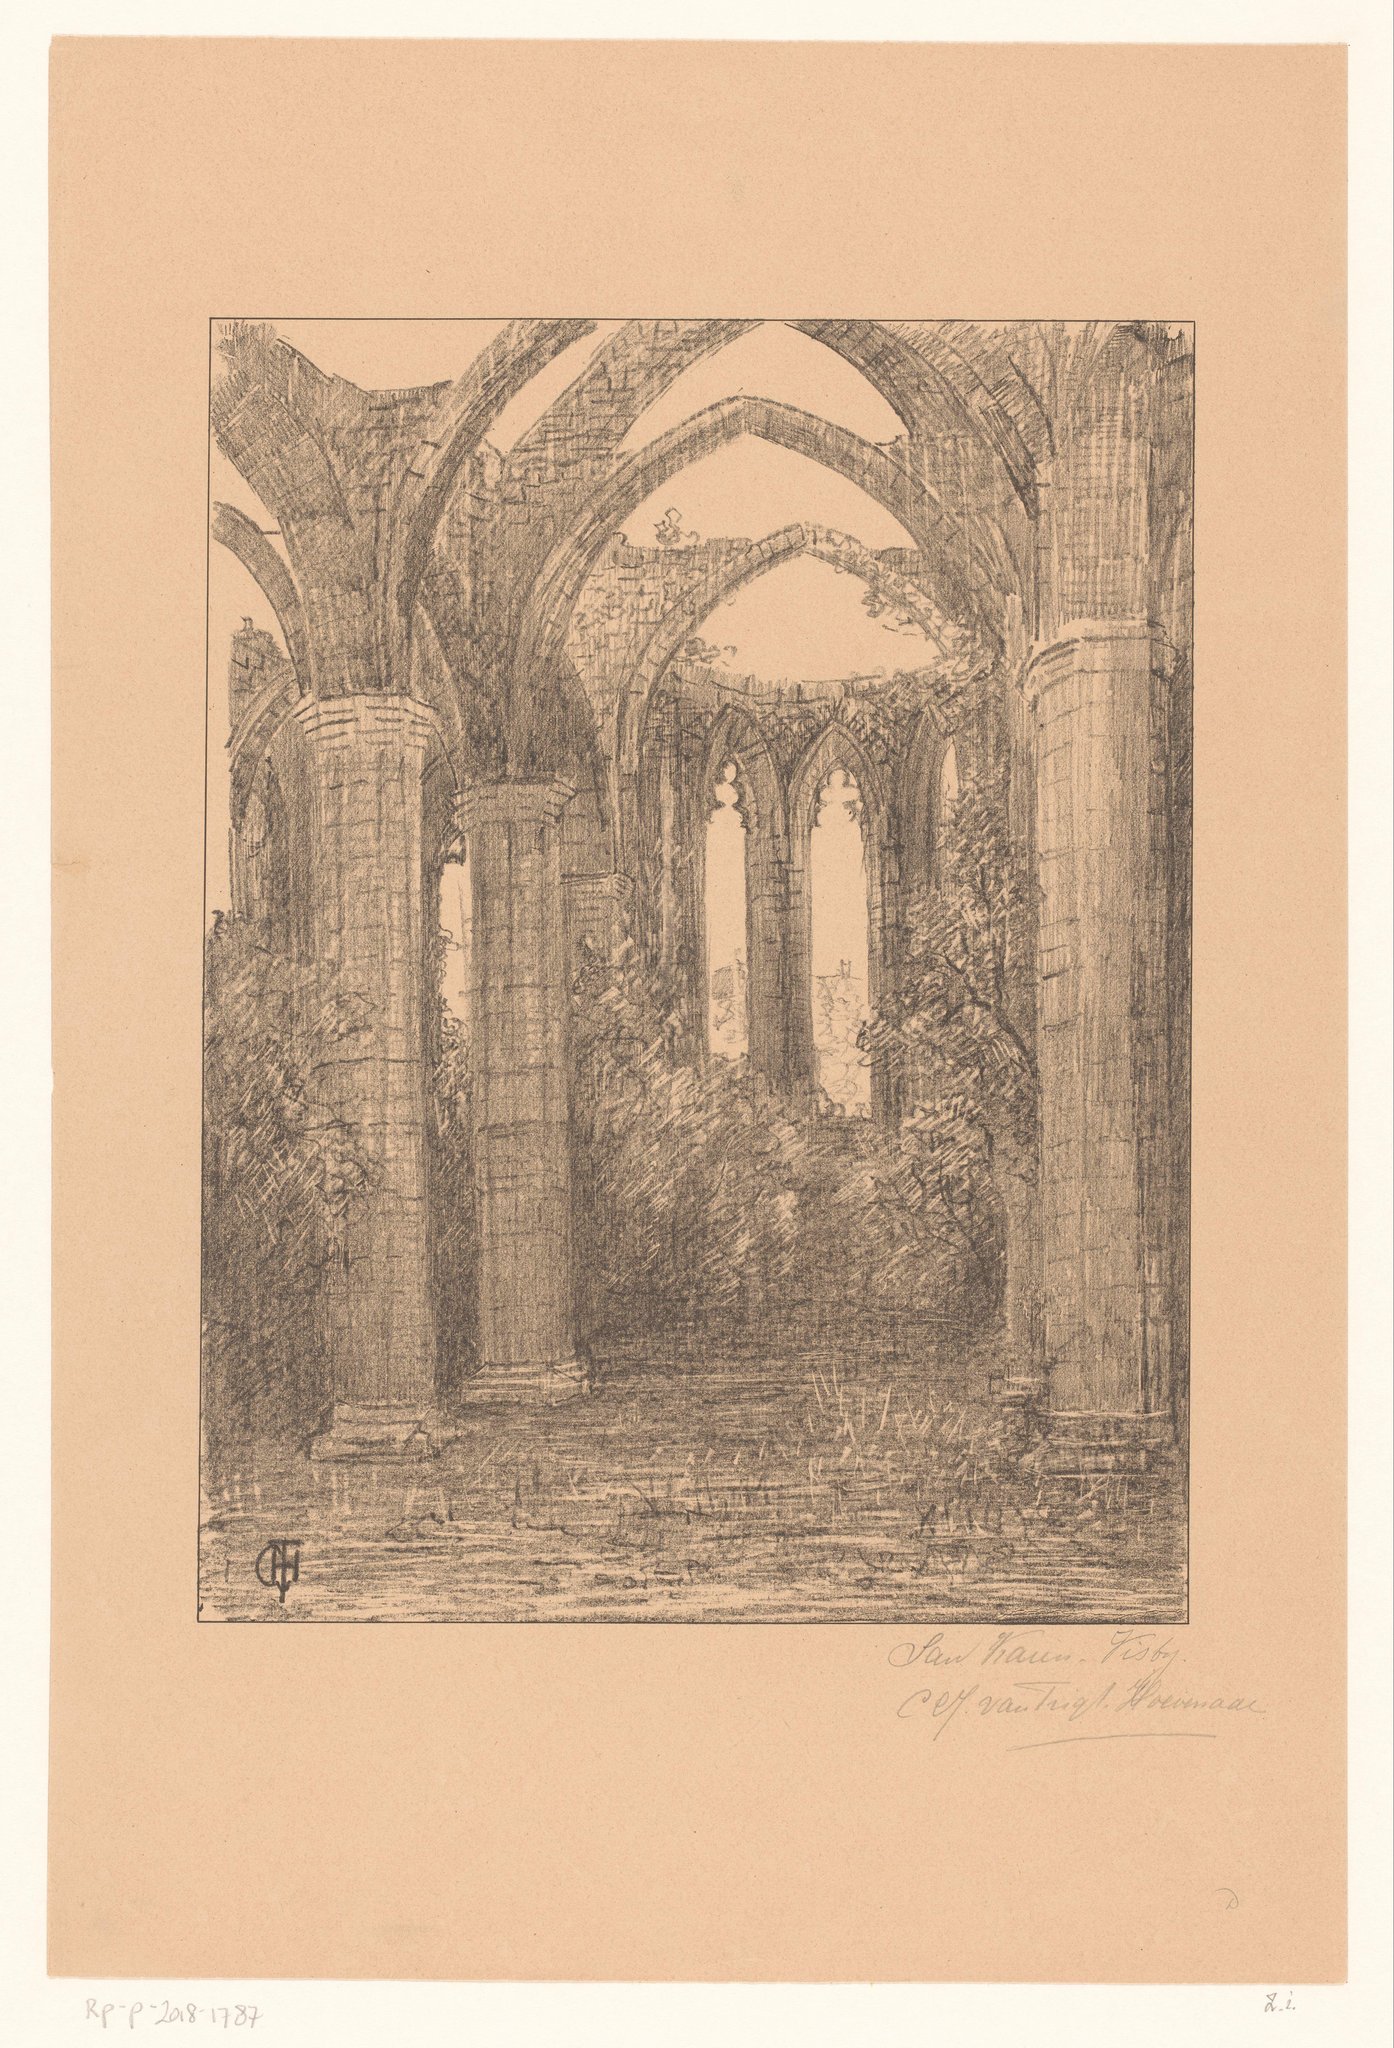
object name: print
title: Ruïne van San Karin op Visby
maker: cornelia christina johanna van trigt-hoevenaar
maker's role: print maker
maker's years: 1854-1924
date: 1864-1910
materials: paper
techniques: lithograph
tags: ruin of church, monastery, etc.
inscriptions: collector's mark: Lugt 2228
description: Zicht vanuit het overwoekerde middenschip waarvan het dak ontbreekt.